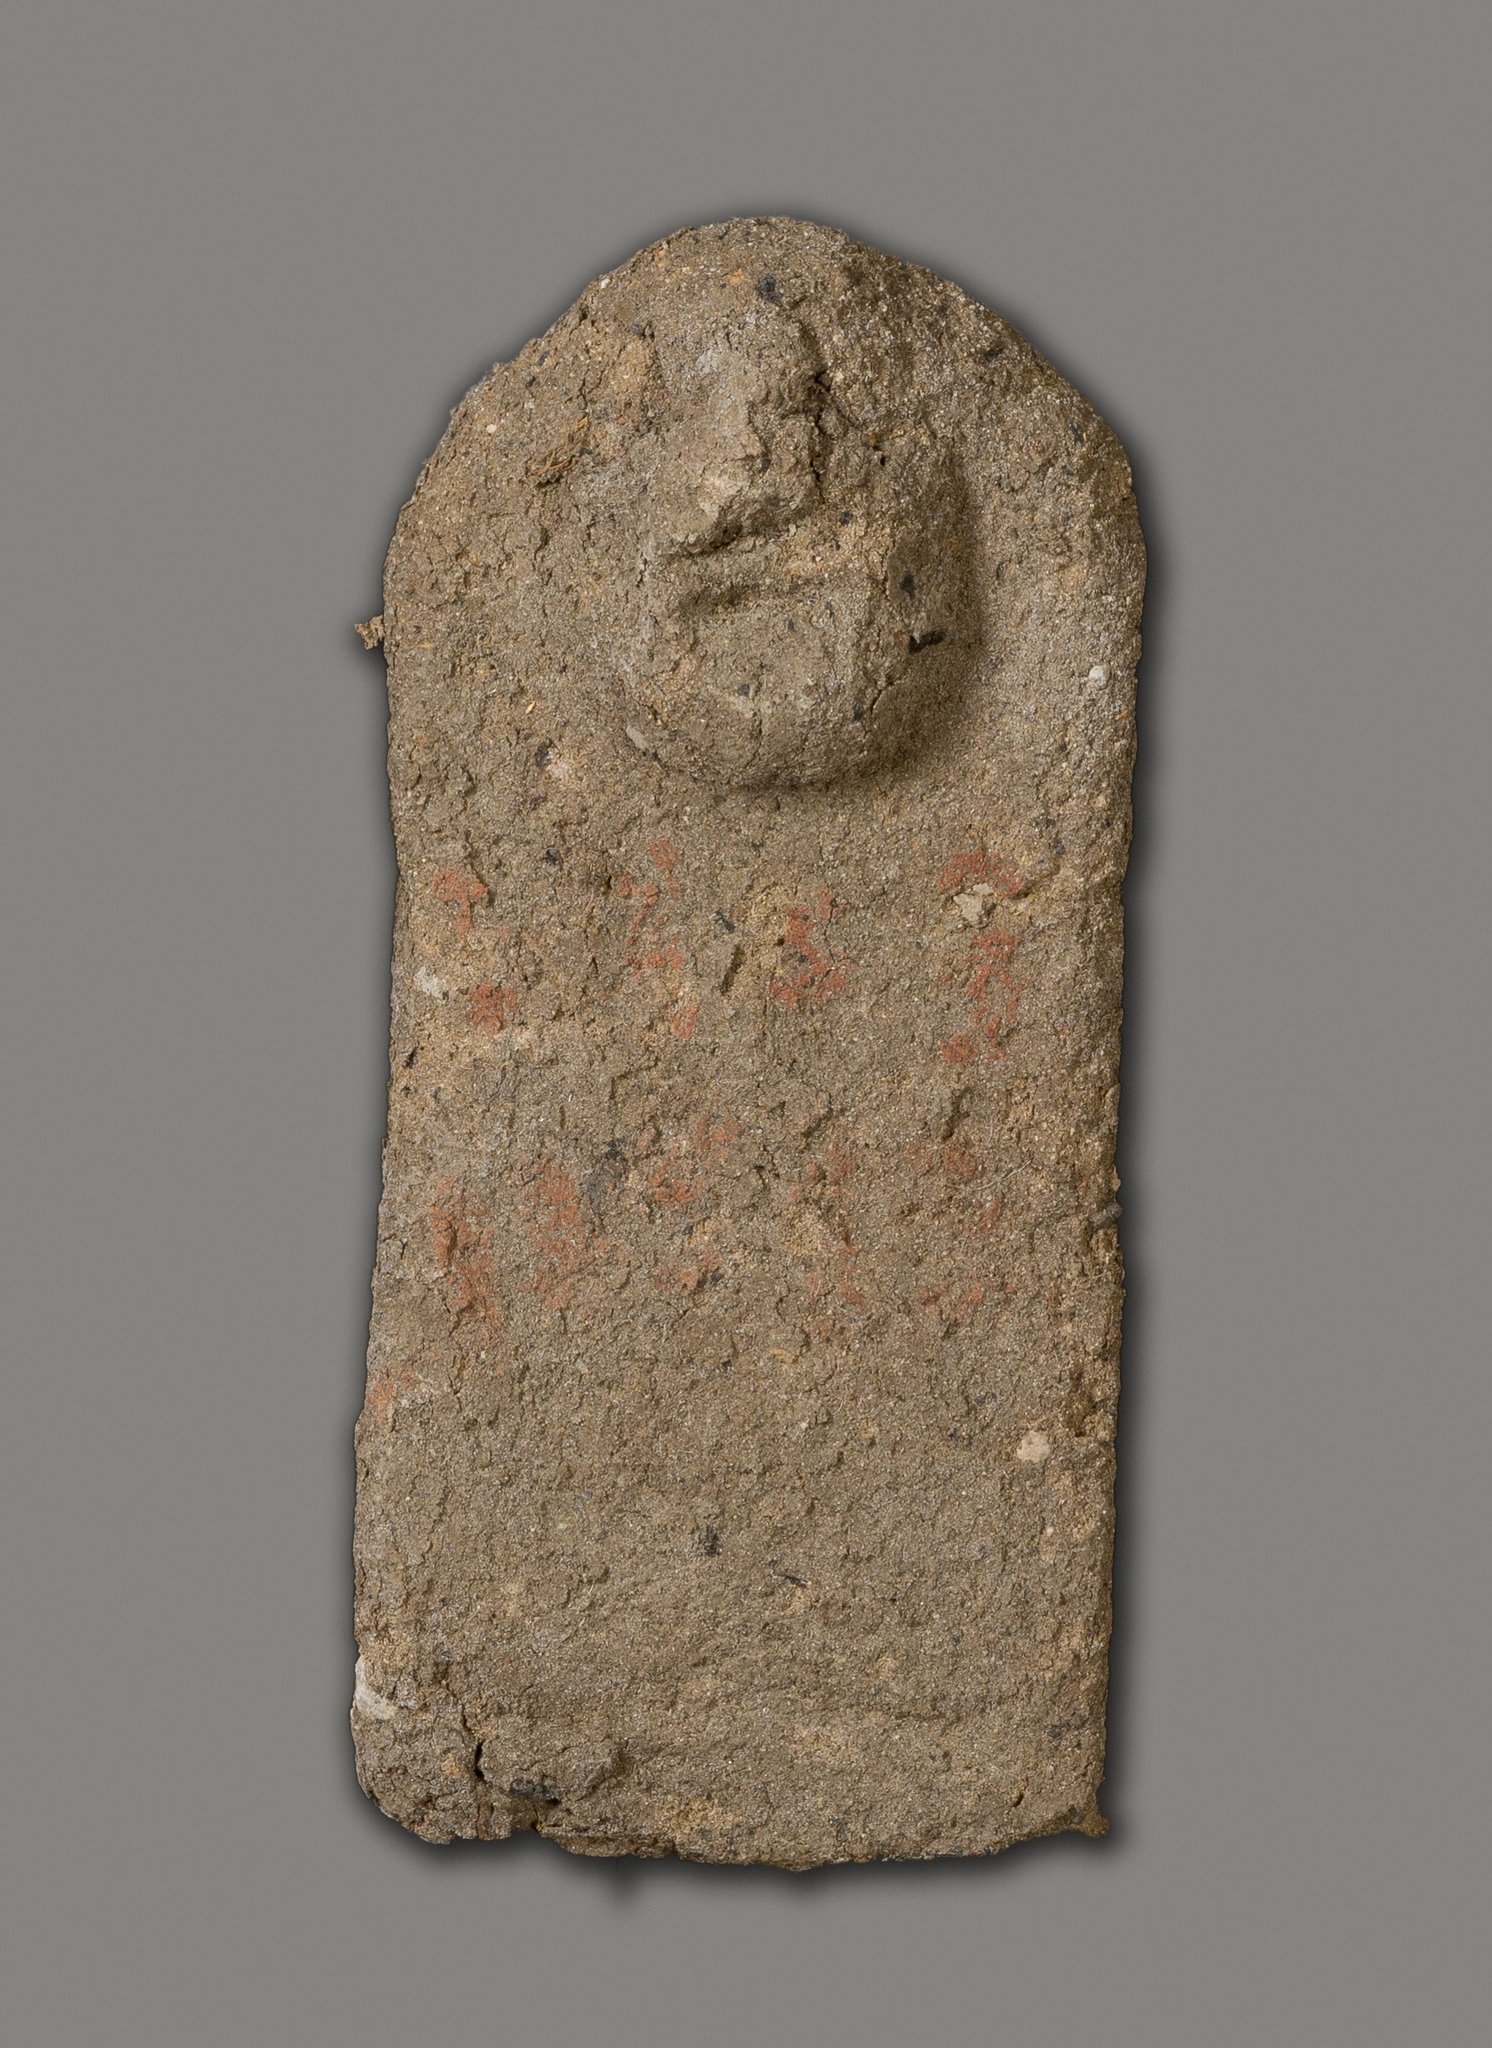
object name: figure, magical, execration, tablet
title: Magical Figure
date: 1802-1550 BCE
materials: clay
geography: egypt